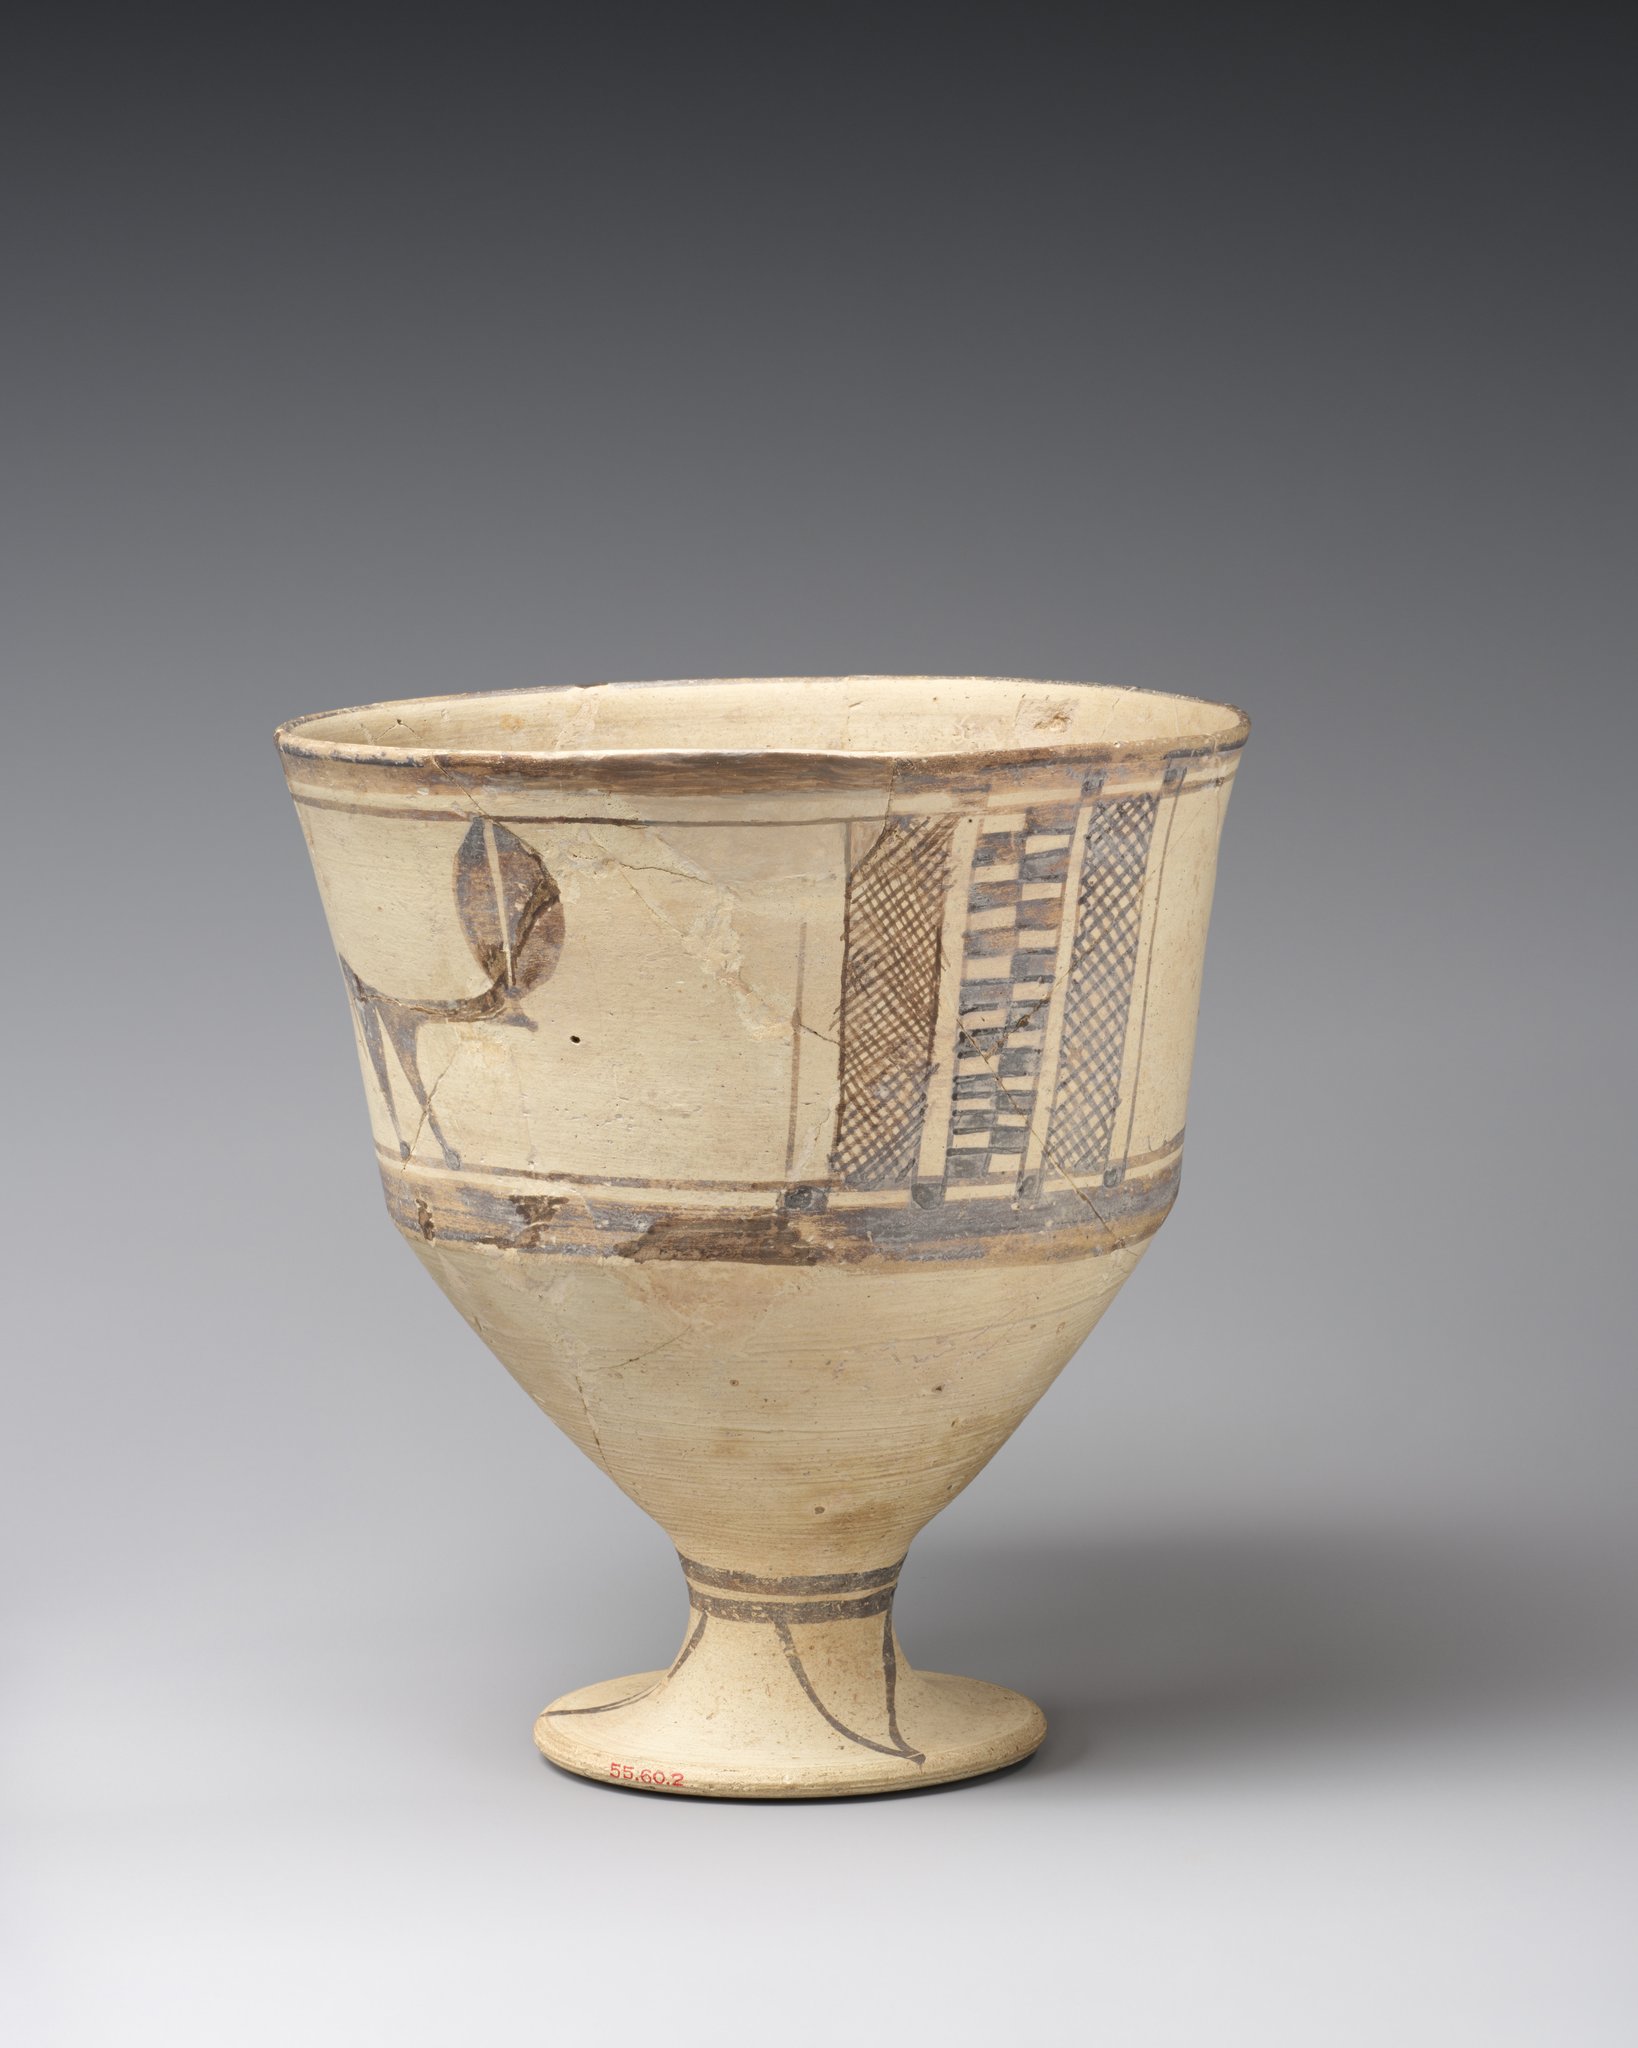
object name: goblet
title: Goblet decorated with quadrupeds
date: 4000-3668 BCE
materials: ceramic, paint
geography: central iran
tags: animals